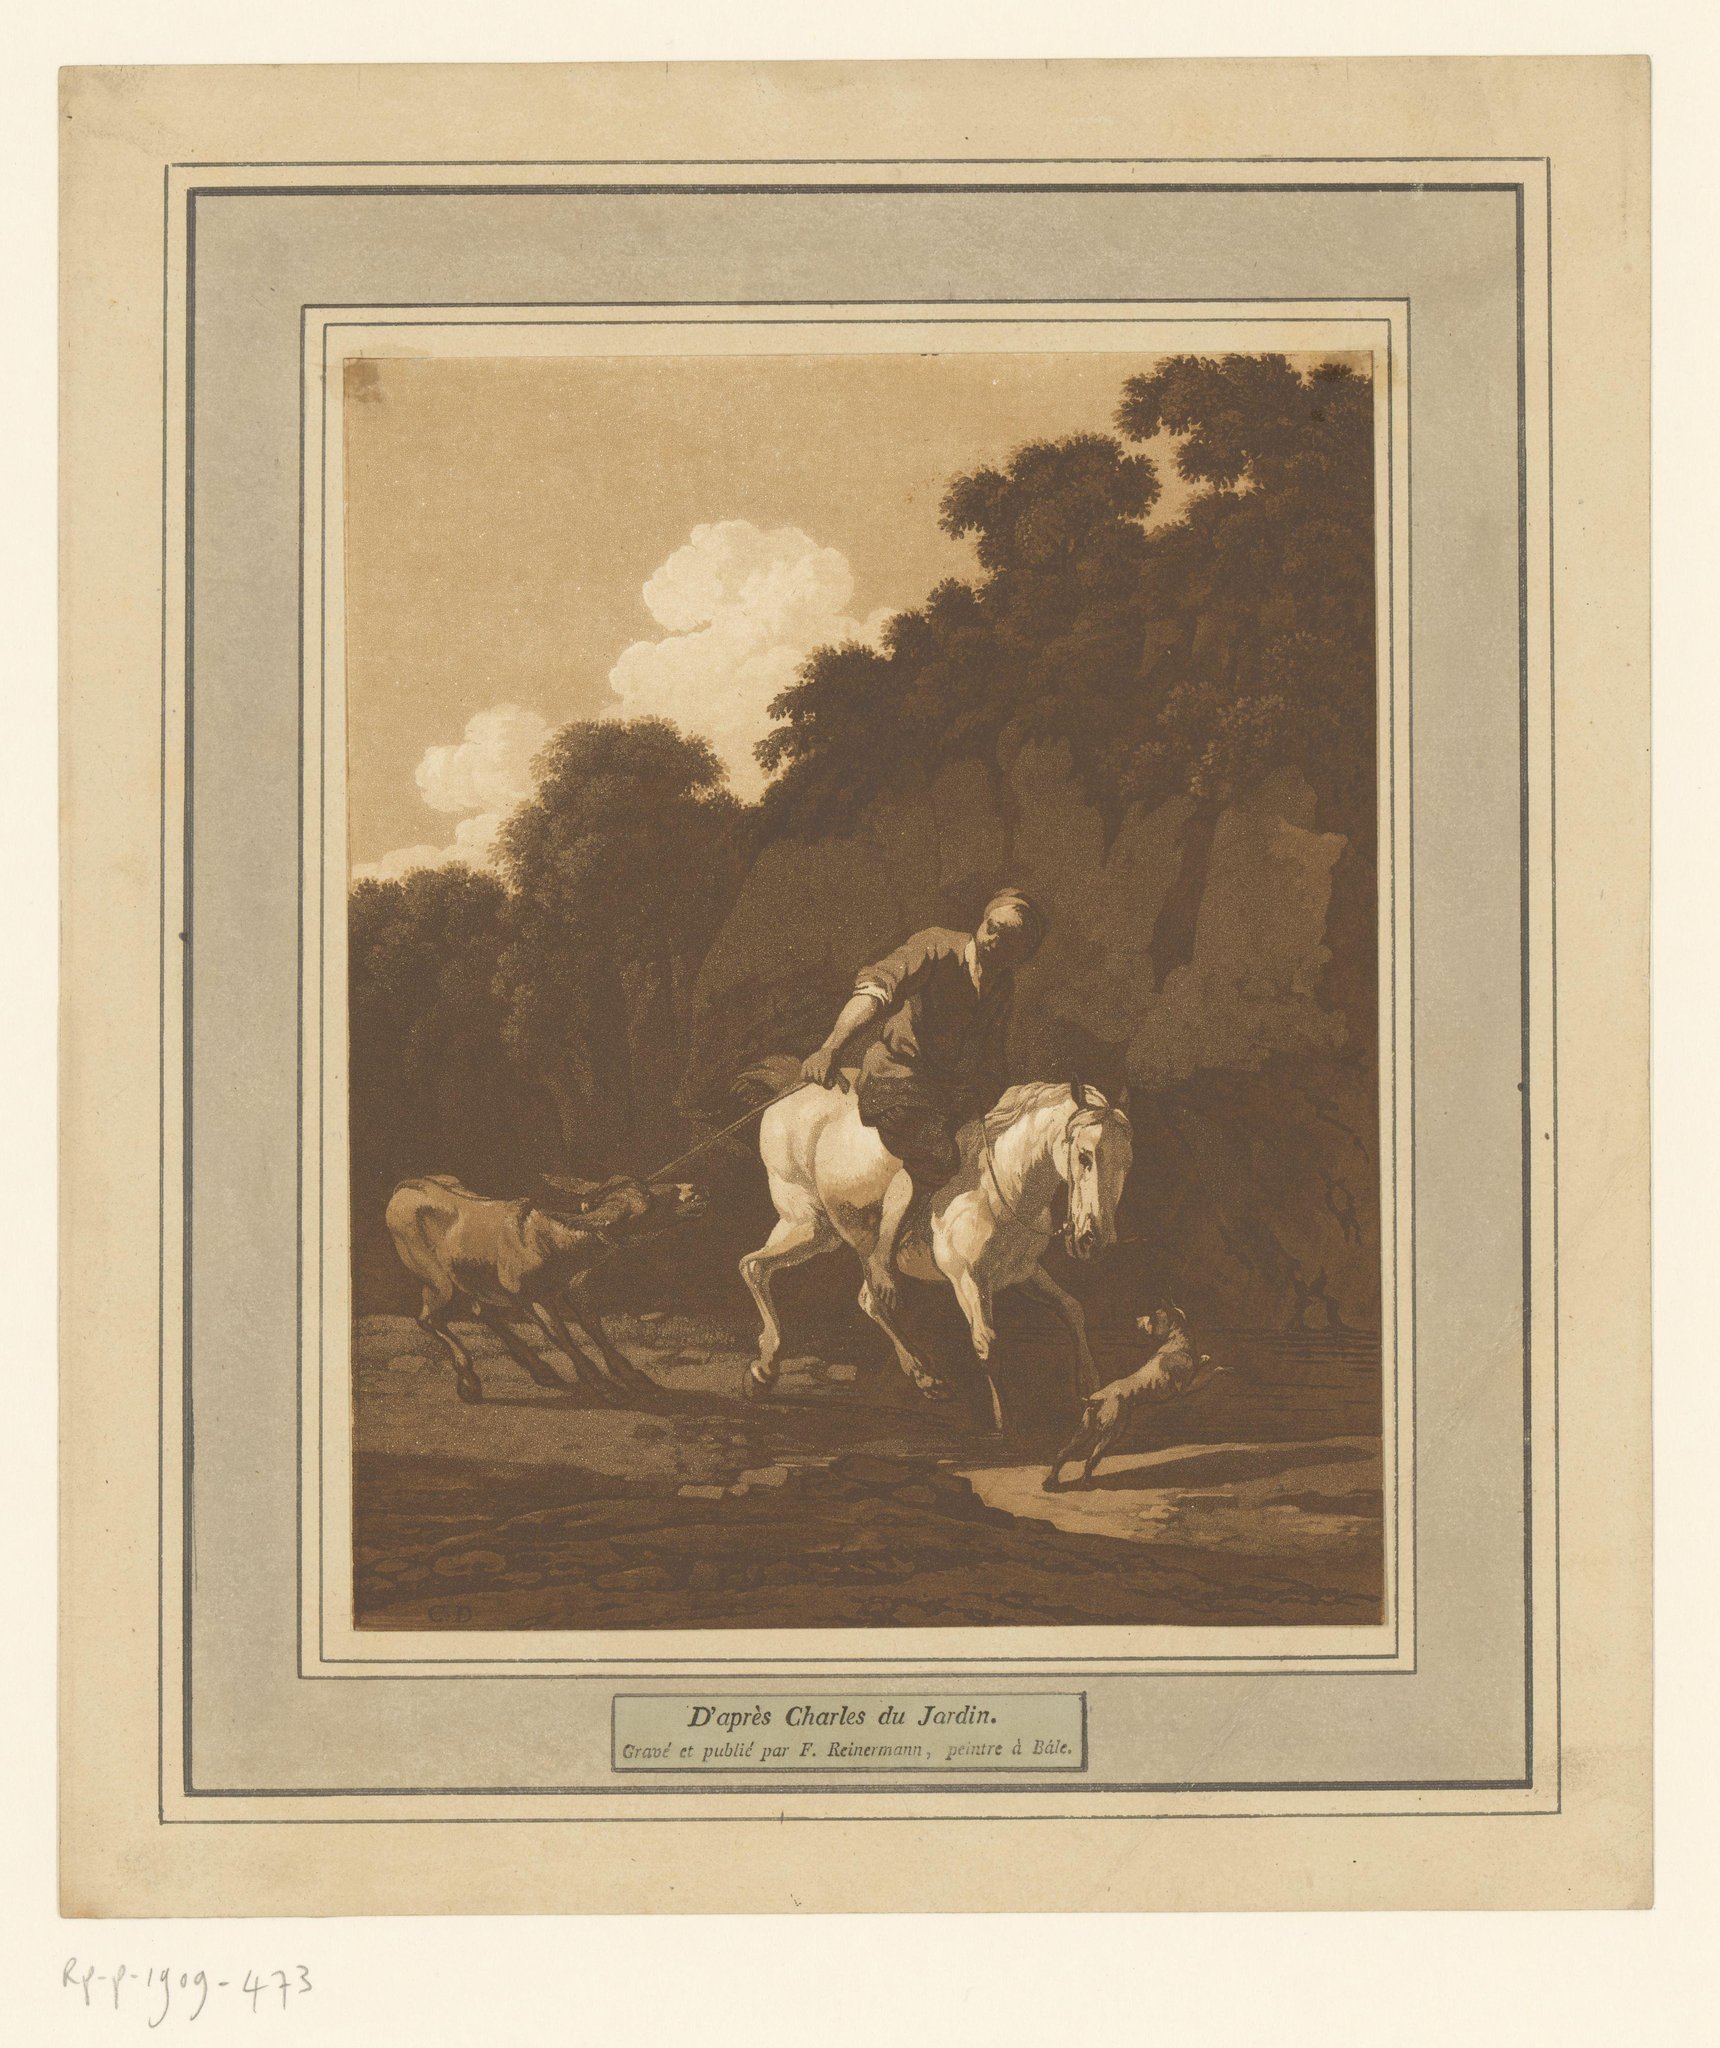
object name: print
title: Herder te paard trekt een muilezel voort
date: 1774-1835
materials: paper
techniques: aquatint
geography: basel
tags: riding a horse, ass, or mule; rider, horseman, mule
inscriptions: collector's mark: Lugt 2228